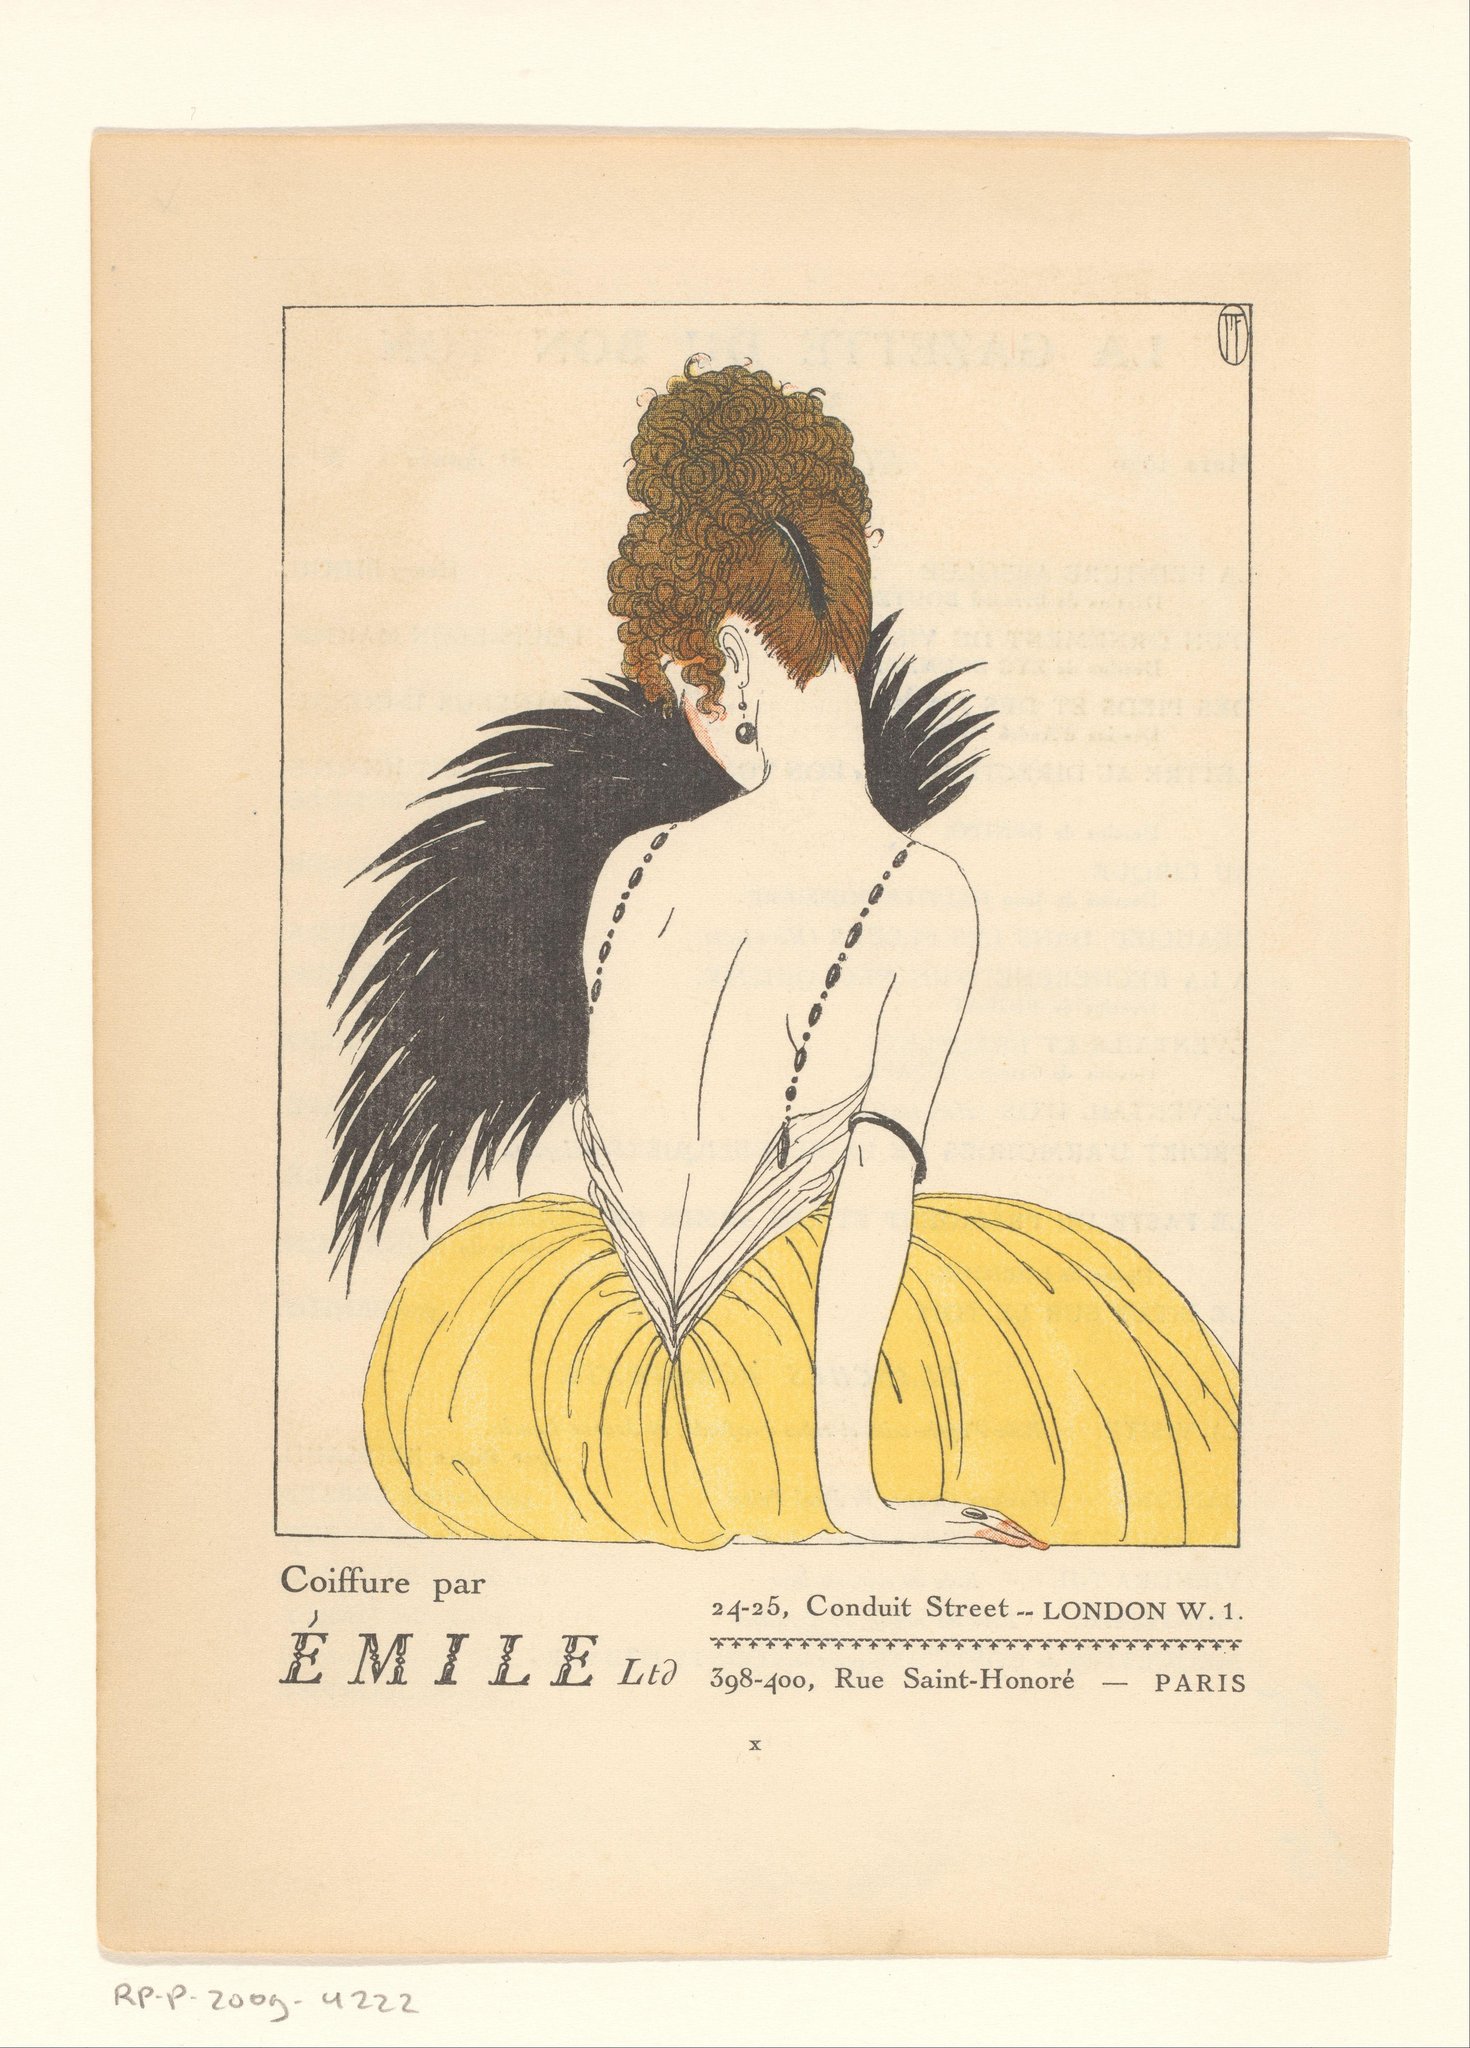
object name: print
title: Gazette du Bon Ton, 1920 - No. 2, X: Coiffure par Émile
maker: lucien vogel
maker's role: publisher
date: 1920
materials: paper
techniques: letterpress printing, lithograph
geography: paris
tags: ear-rings (+ women's clothes), styles of hairdress - aa - ~ women, fashion plates, bracelet, wristlet (+ women's clothes)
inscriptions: date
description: Advertentie voor coiffeur Emile, in Parijs en in Londen. Zittende vrouw in gele avondjapon, op de rug gezien, met zwarte waaier. In Gazette du Bon, maart 1920, No. 2.